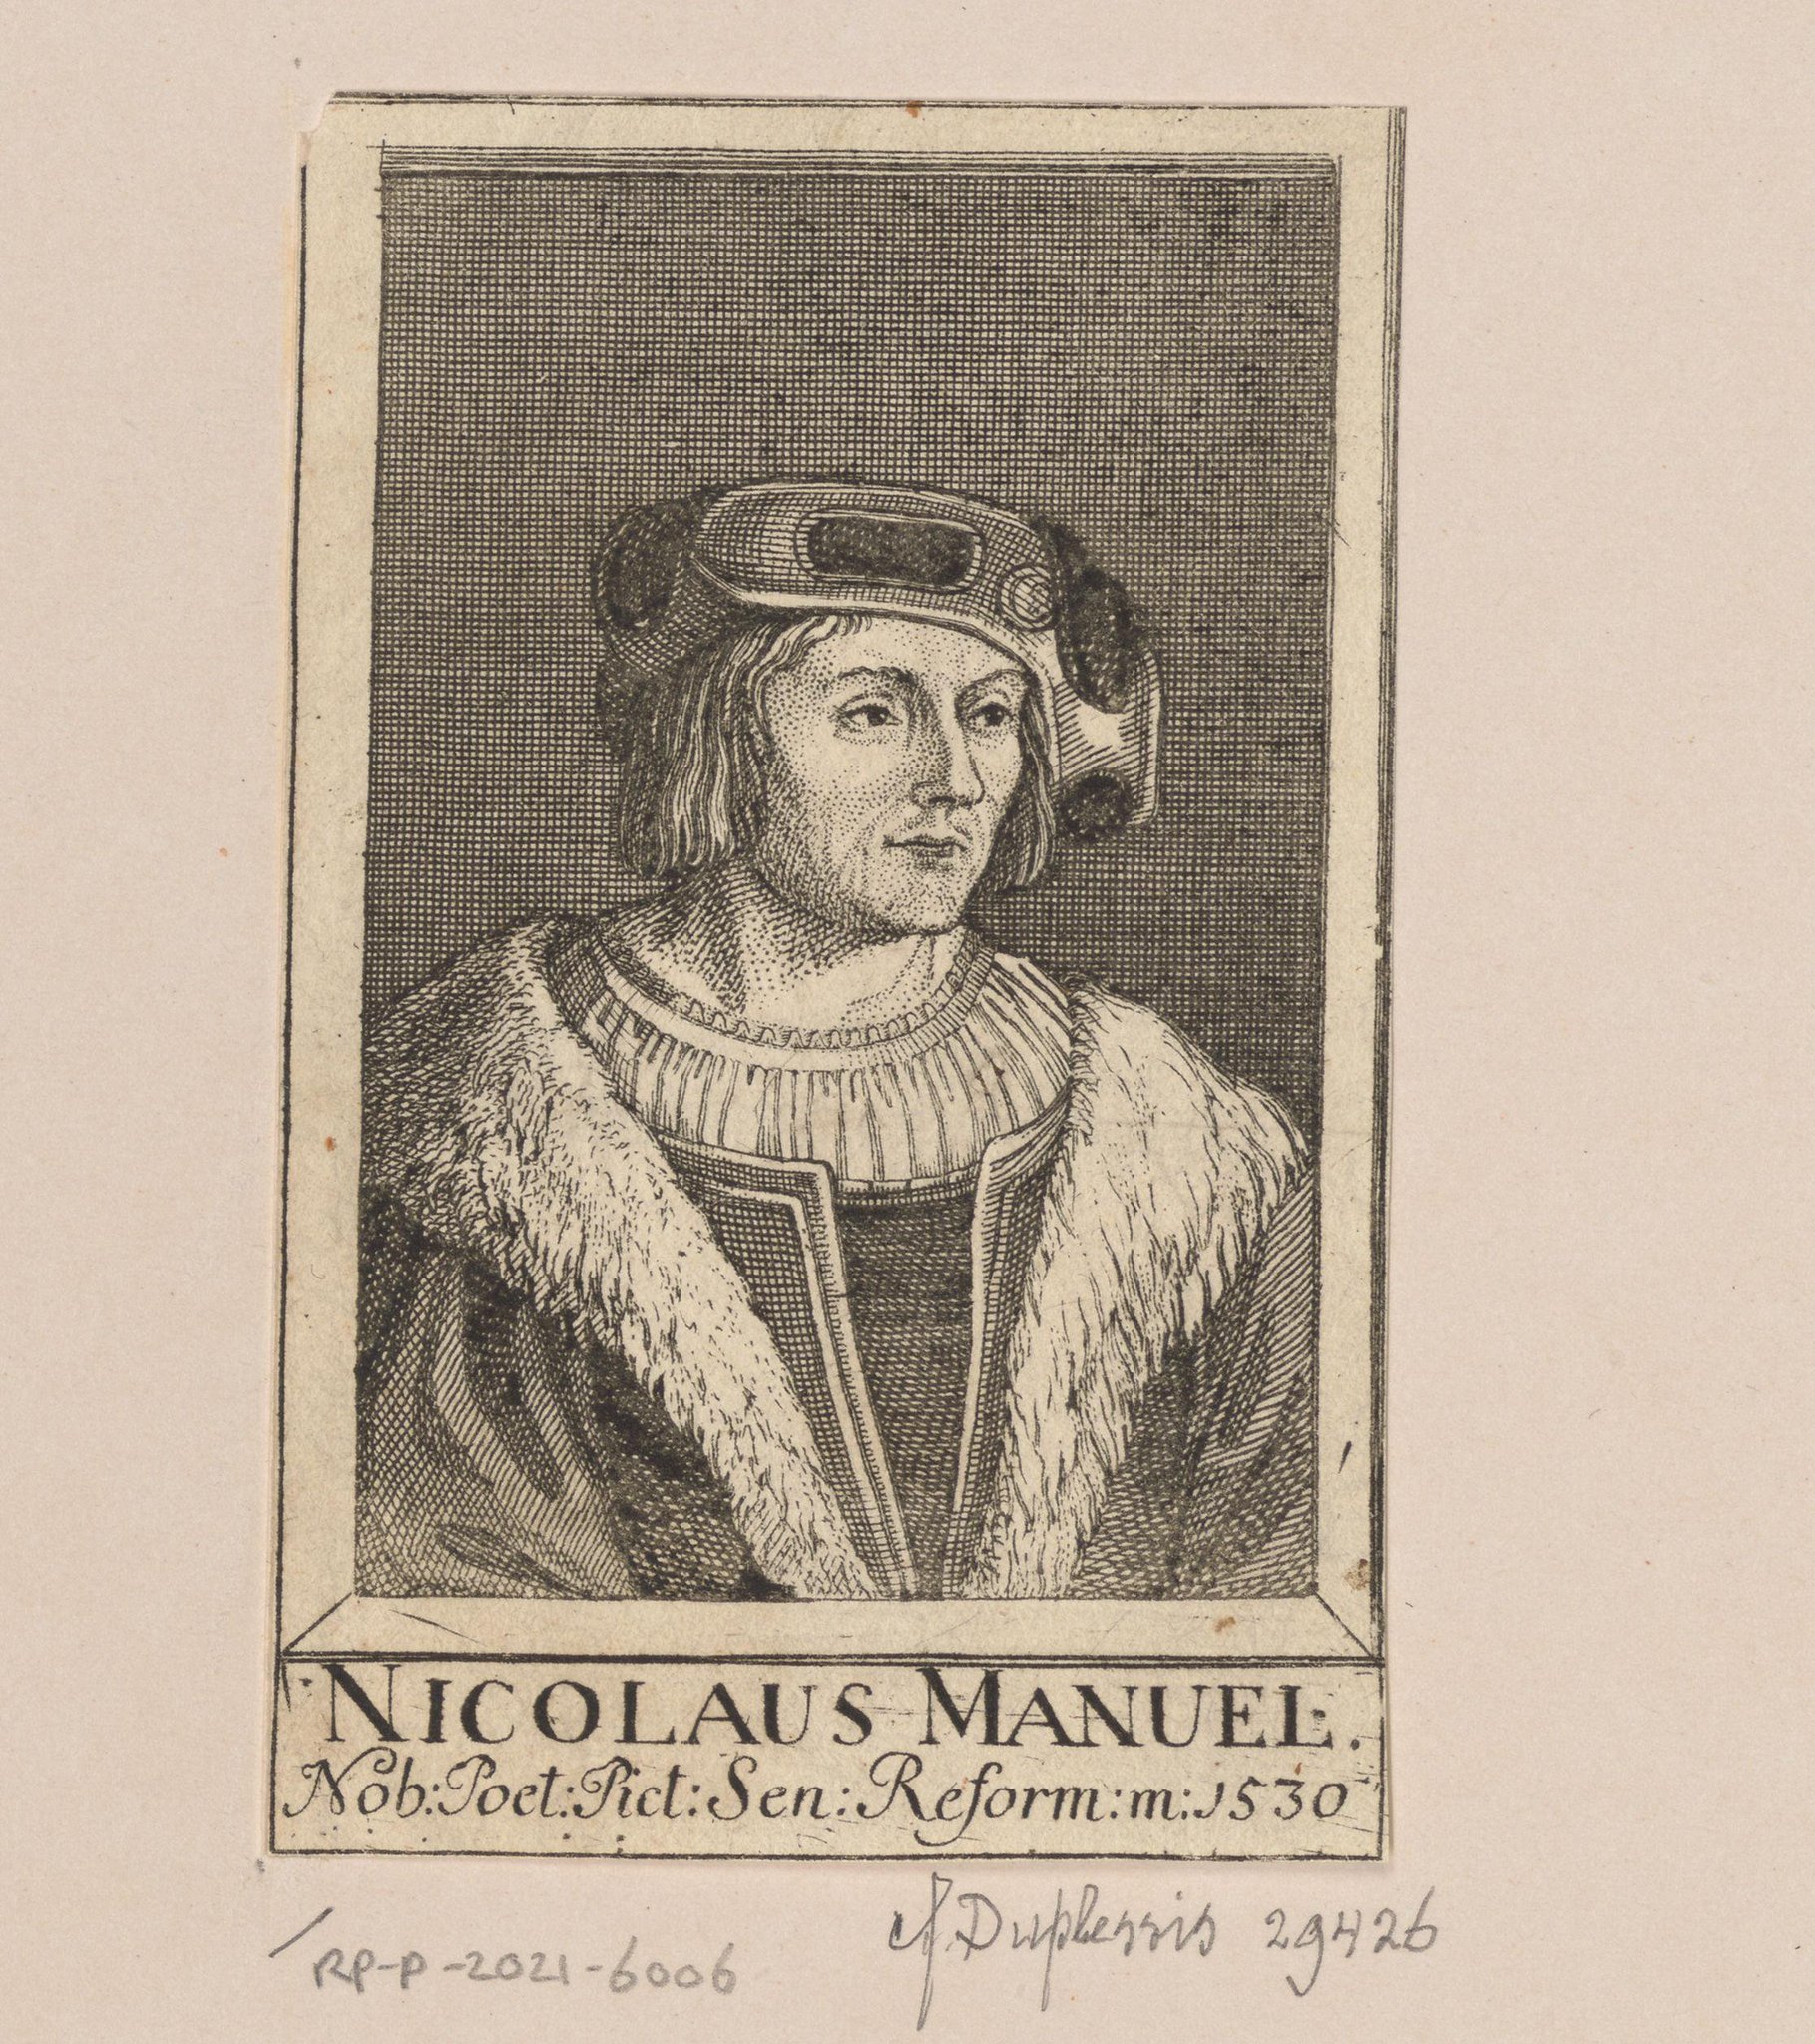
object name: book illustration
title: Portret van Niklaus Manuel Deutsch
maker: Anonymous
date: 1742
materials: paper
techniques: etching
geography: switzerland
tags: print maker, niklaus manuel deutsch, historical persons, portrait of a writer, portrait, self-portrait of artist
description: Prent waarschijnlijk uit: Scheurer, Samuel. Leben und Wichtige Verrichtungen Niclaus Manuels (...). Bern: Johann Bondelin, 1742, dl. 5.